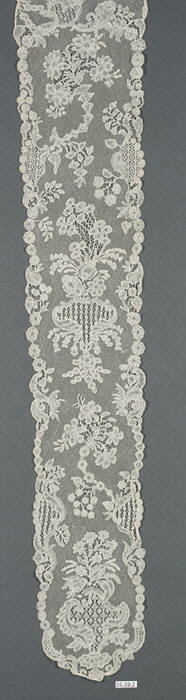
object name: lappet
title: Pair of lappets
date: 1701-1800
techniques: lace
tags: flowers